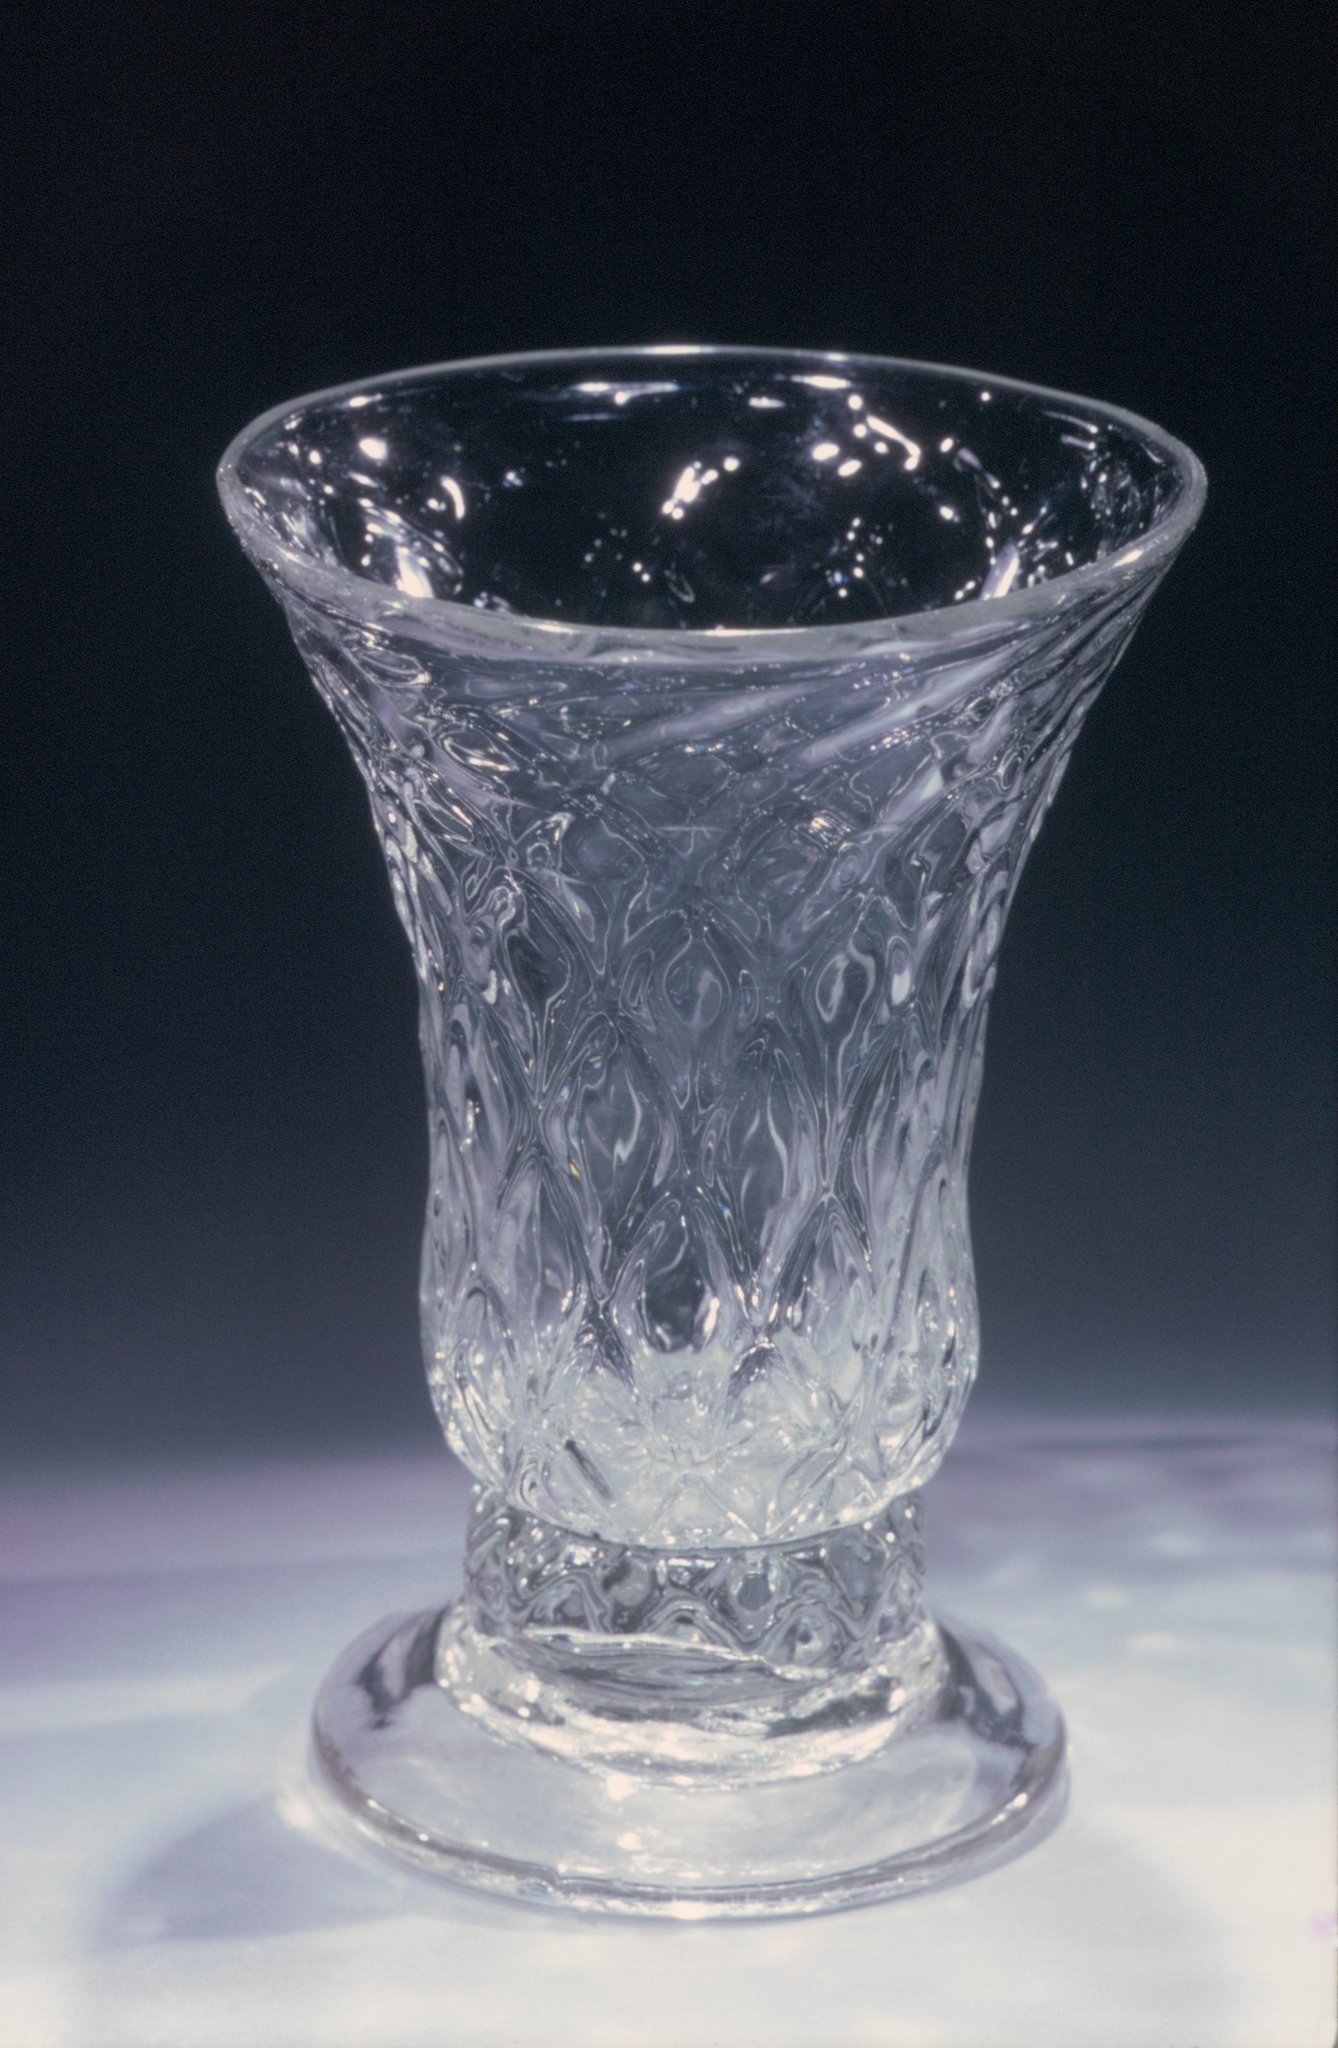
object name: jelly glass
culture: american or british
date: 1785-1825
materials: glass, lead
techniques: glassblowing, molding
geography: england